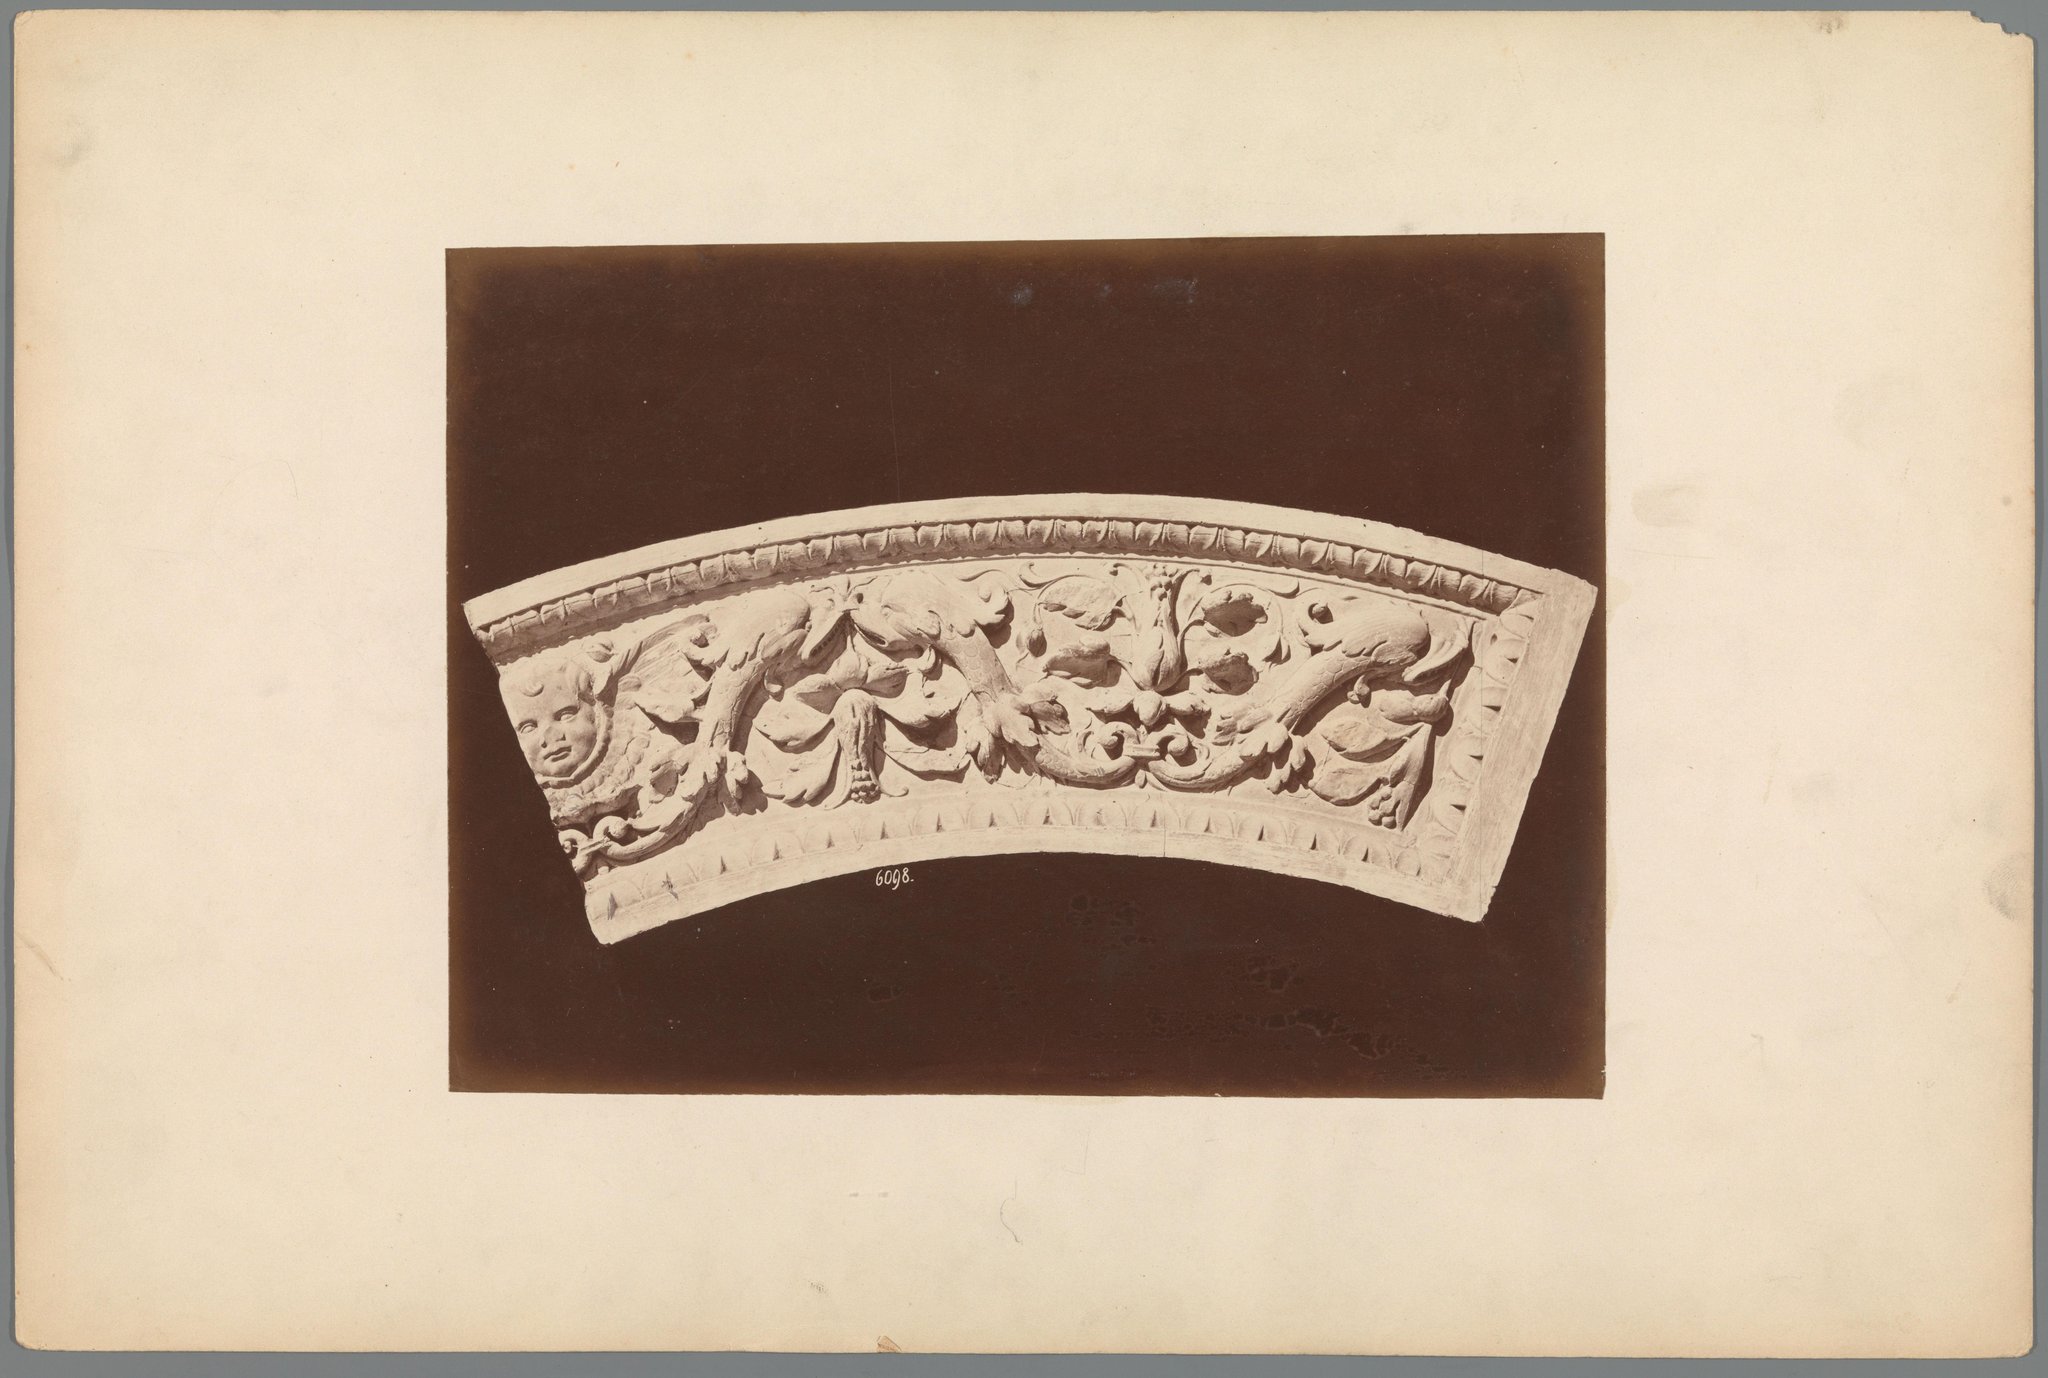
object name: photograph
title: Halfrond reliëf met plantmotieven en een putto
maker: Anonymous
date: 1875-1900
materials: cardboard, photographic support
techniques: albumen print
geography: europe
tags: cupids: 'amores', 'amoretti', 'putti', ornament derived from plant forms, sculpture (+ relief ~ sculpture), europe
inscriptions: collector's mark: Lugt 3937, number: ‘6098.’